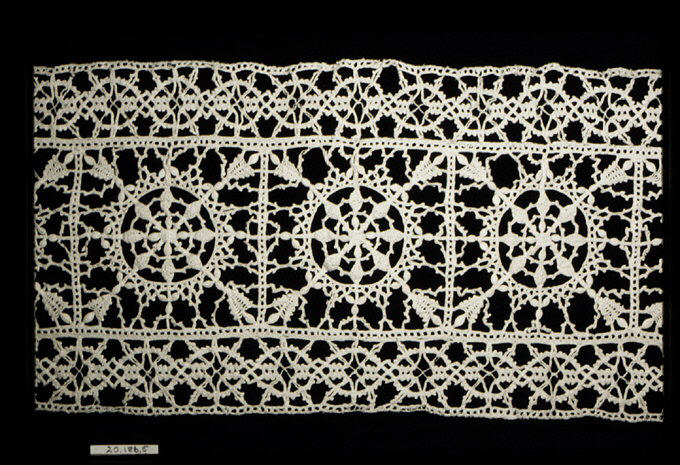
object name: insertion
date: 1501-1700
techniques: lace